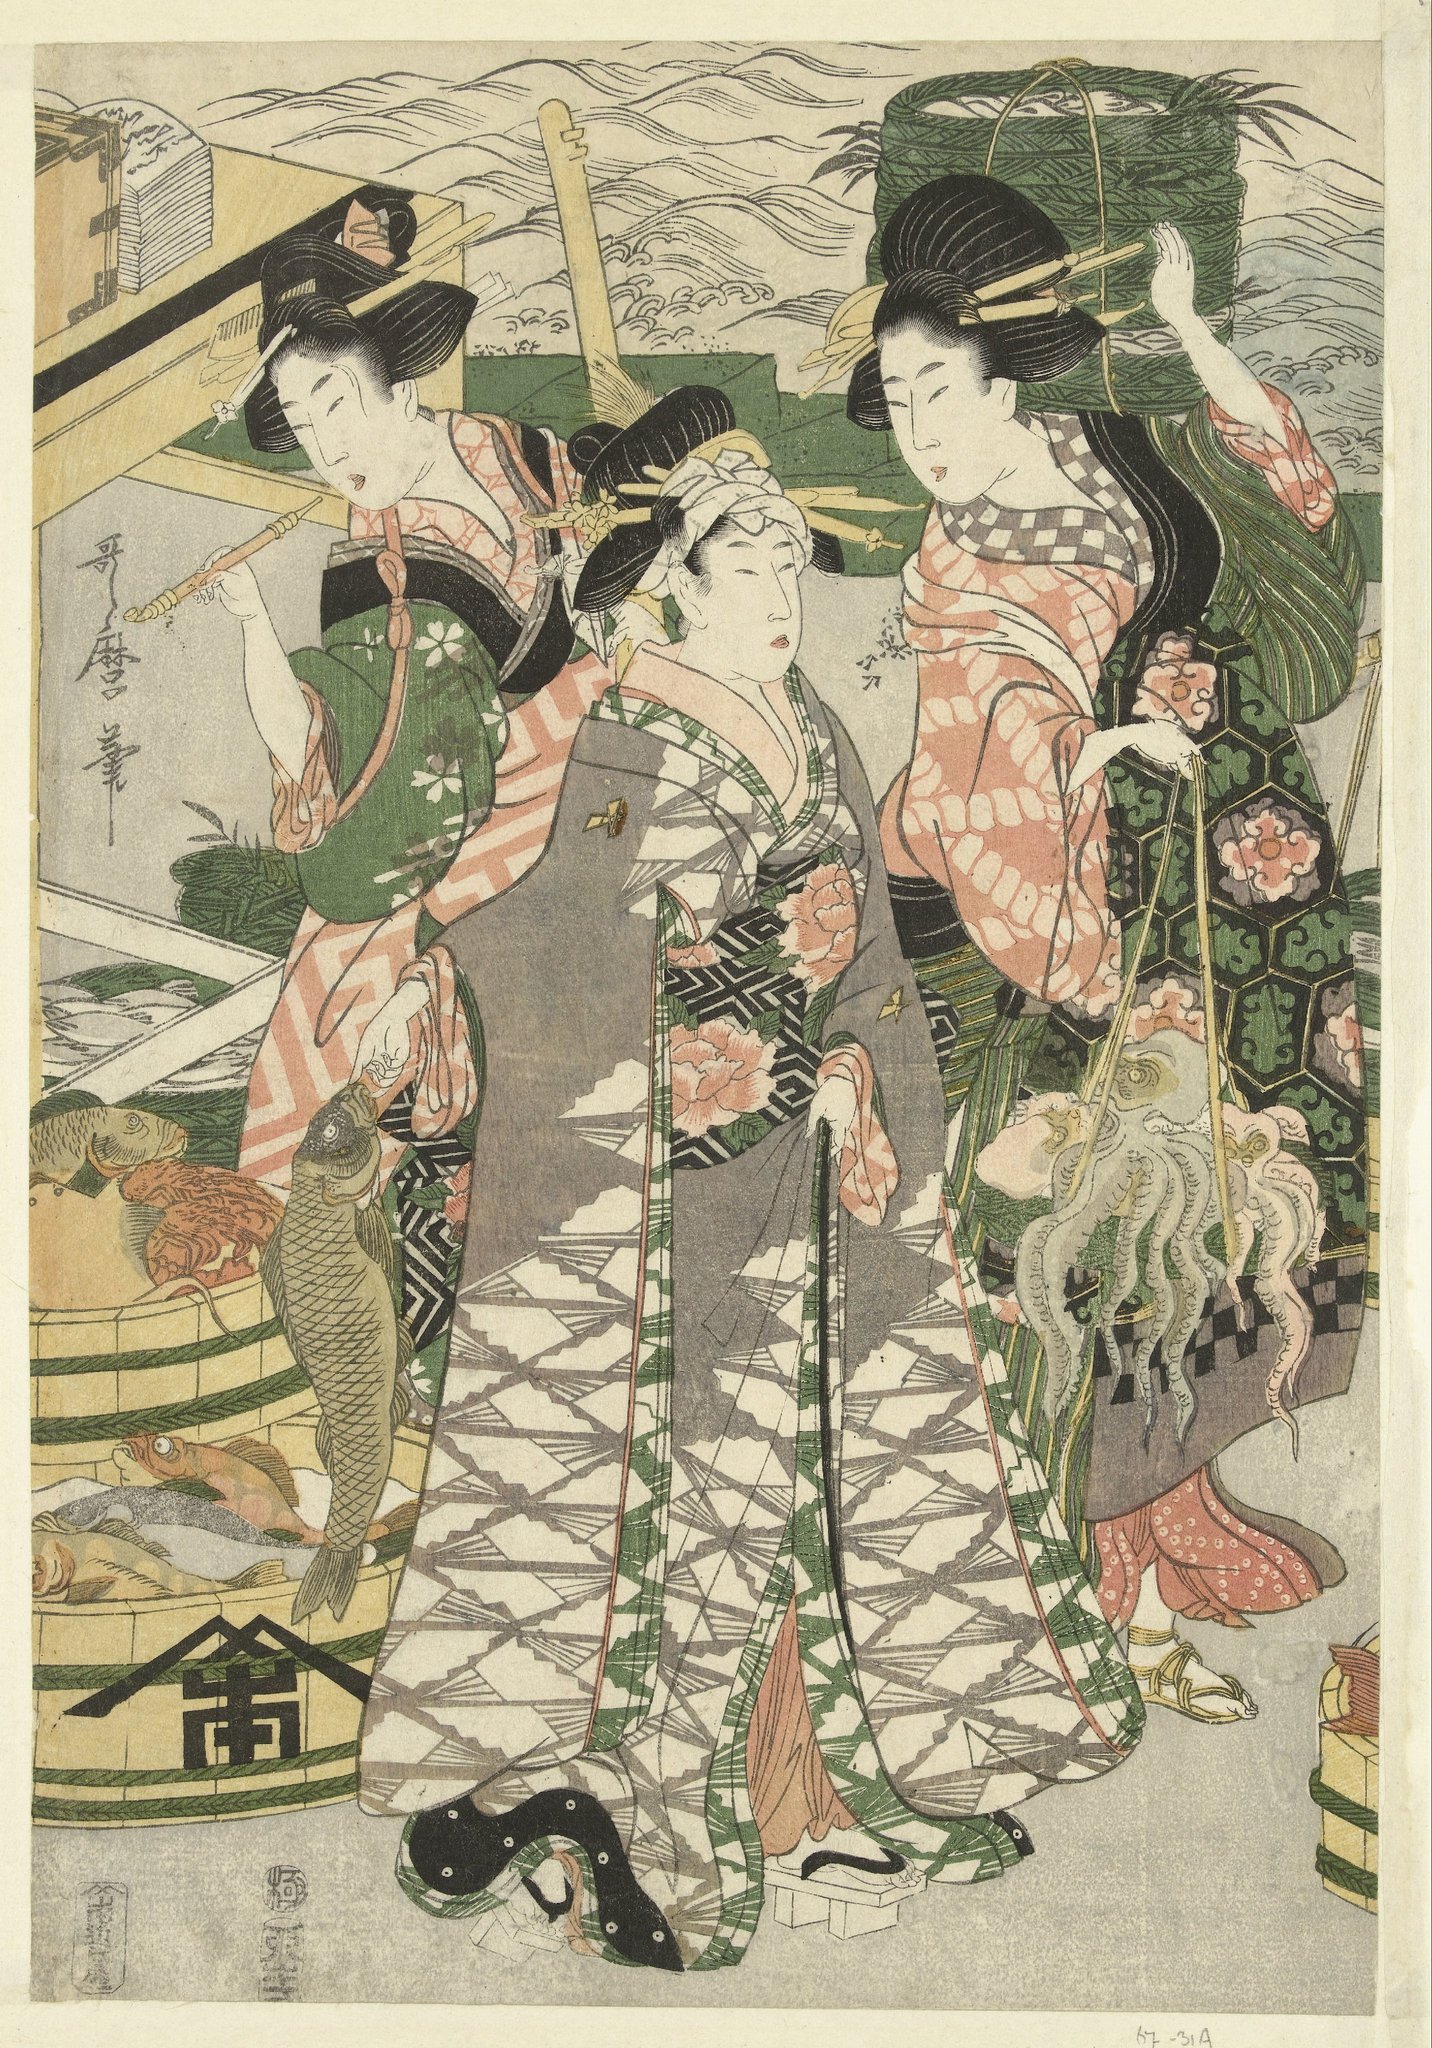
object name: print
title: Gezicht op de vismarkt op het strand te Shiba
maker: kitagawa utamaro (ii)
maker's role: print maker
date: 1807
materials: paper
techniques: woodcut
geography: japan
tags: adult woman (+ three persons), market, beach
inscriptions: date